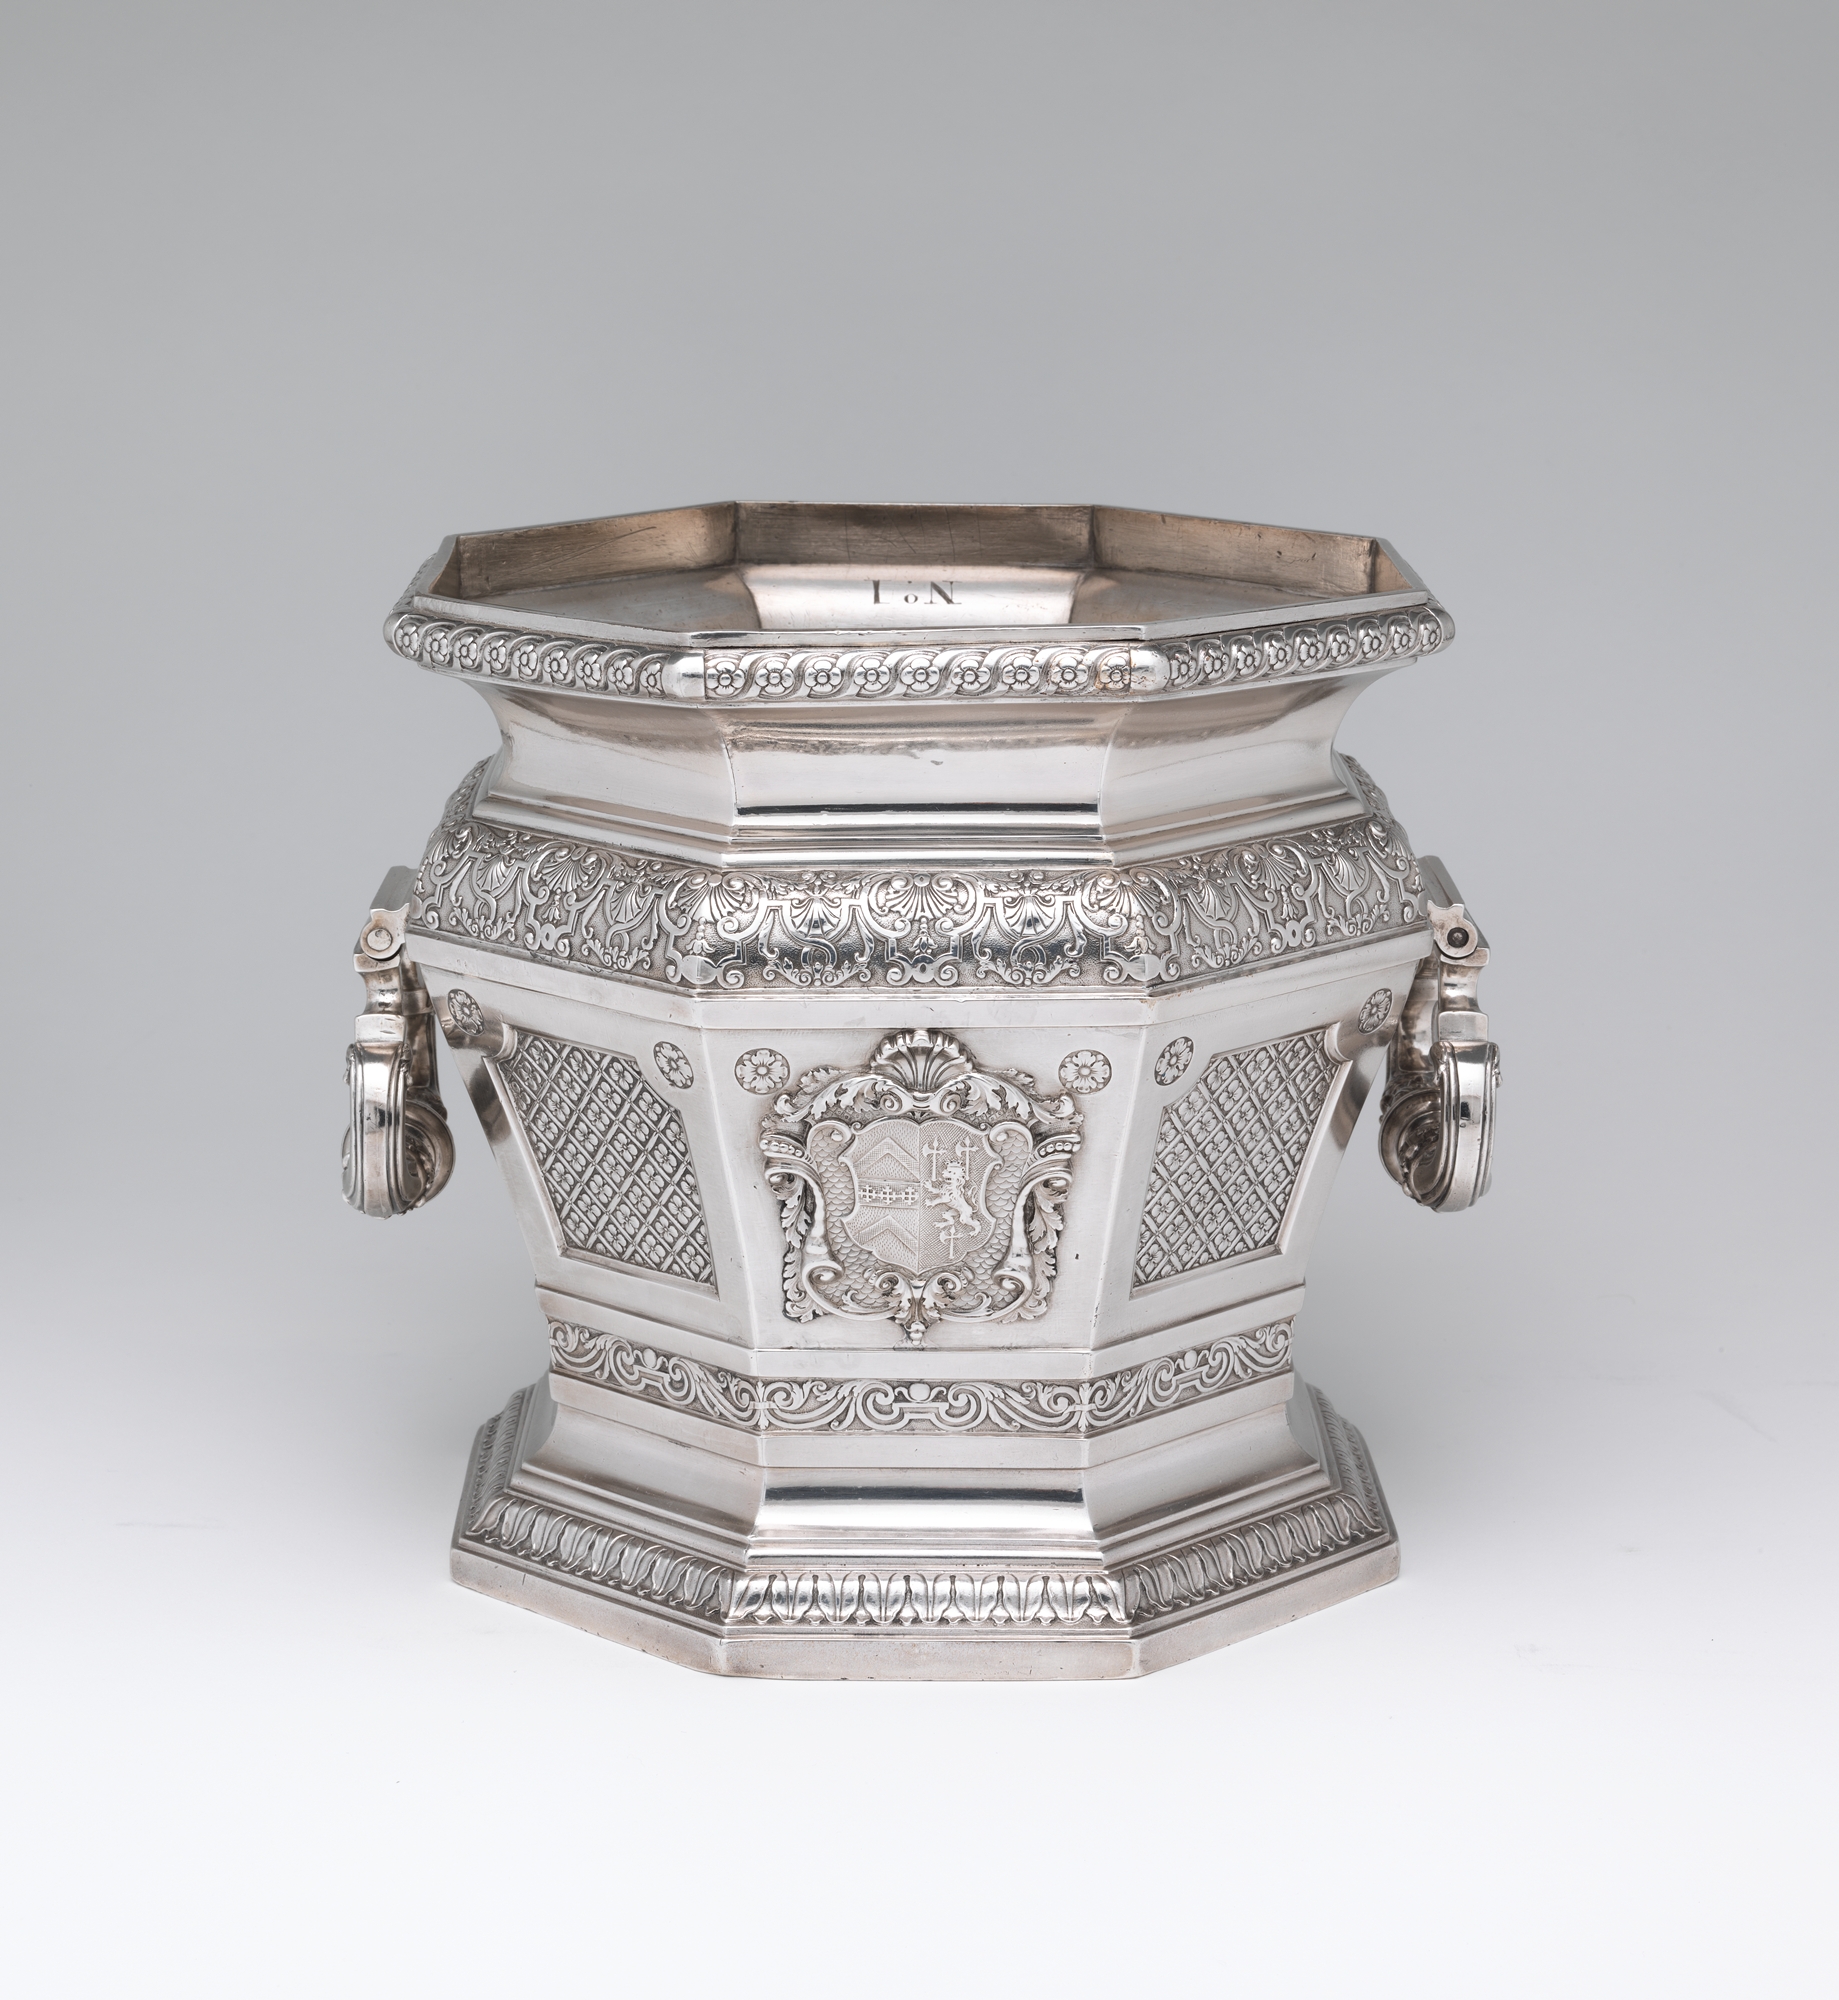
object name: wine cooler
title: Wine cooler (one of a pair)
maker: william lukin i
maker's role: maker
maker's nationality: british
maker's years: 1699-1755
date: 1716-1717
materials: silver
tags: coat of arms